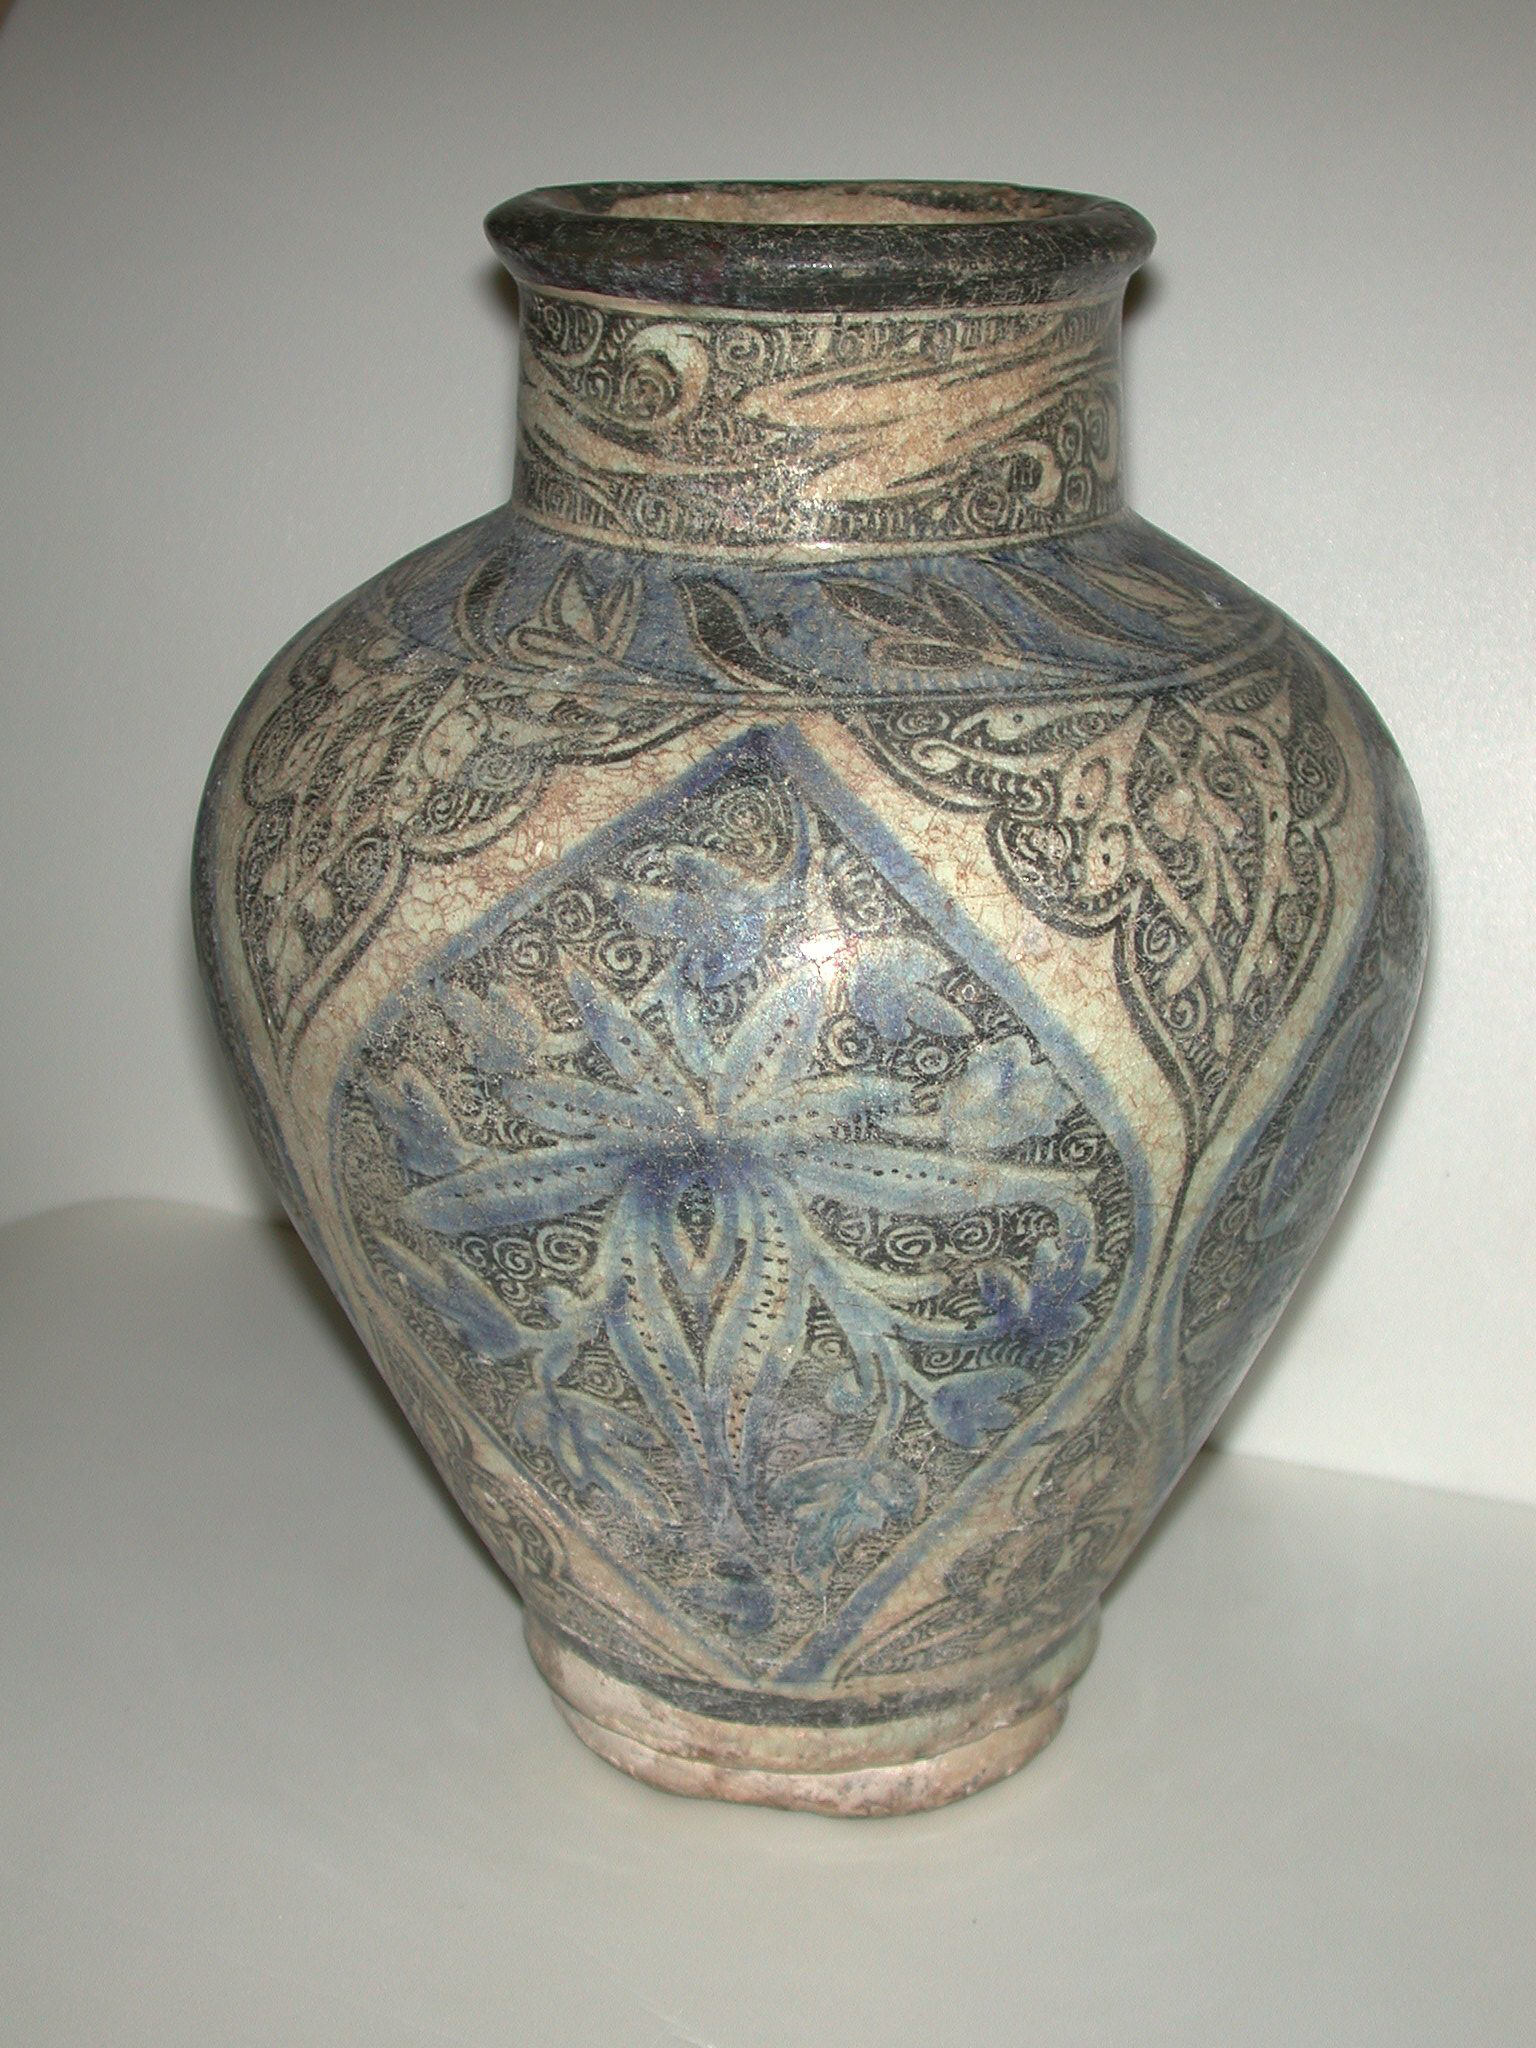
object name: jar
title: Storage Jar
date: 1301-1400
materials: glaze, stonepaste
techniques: painting, polychrome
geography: syria